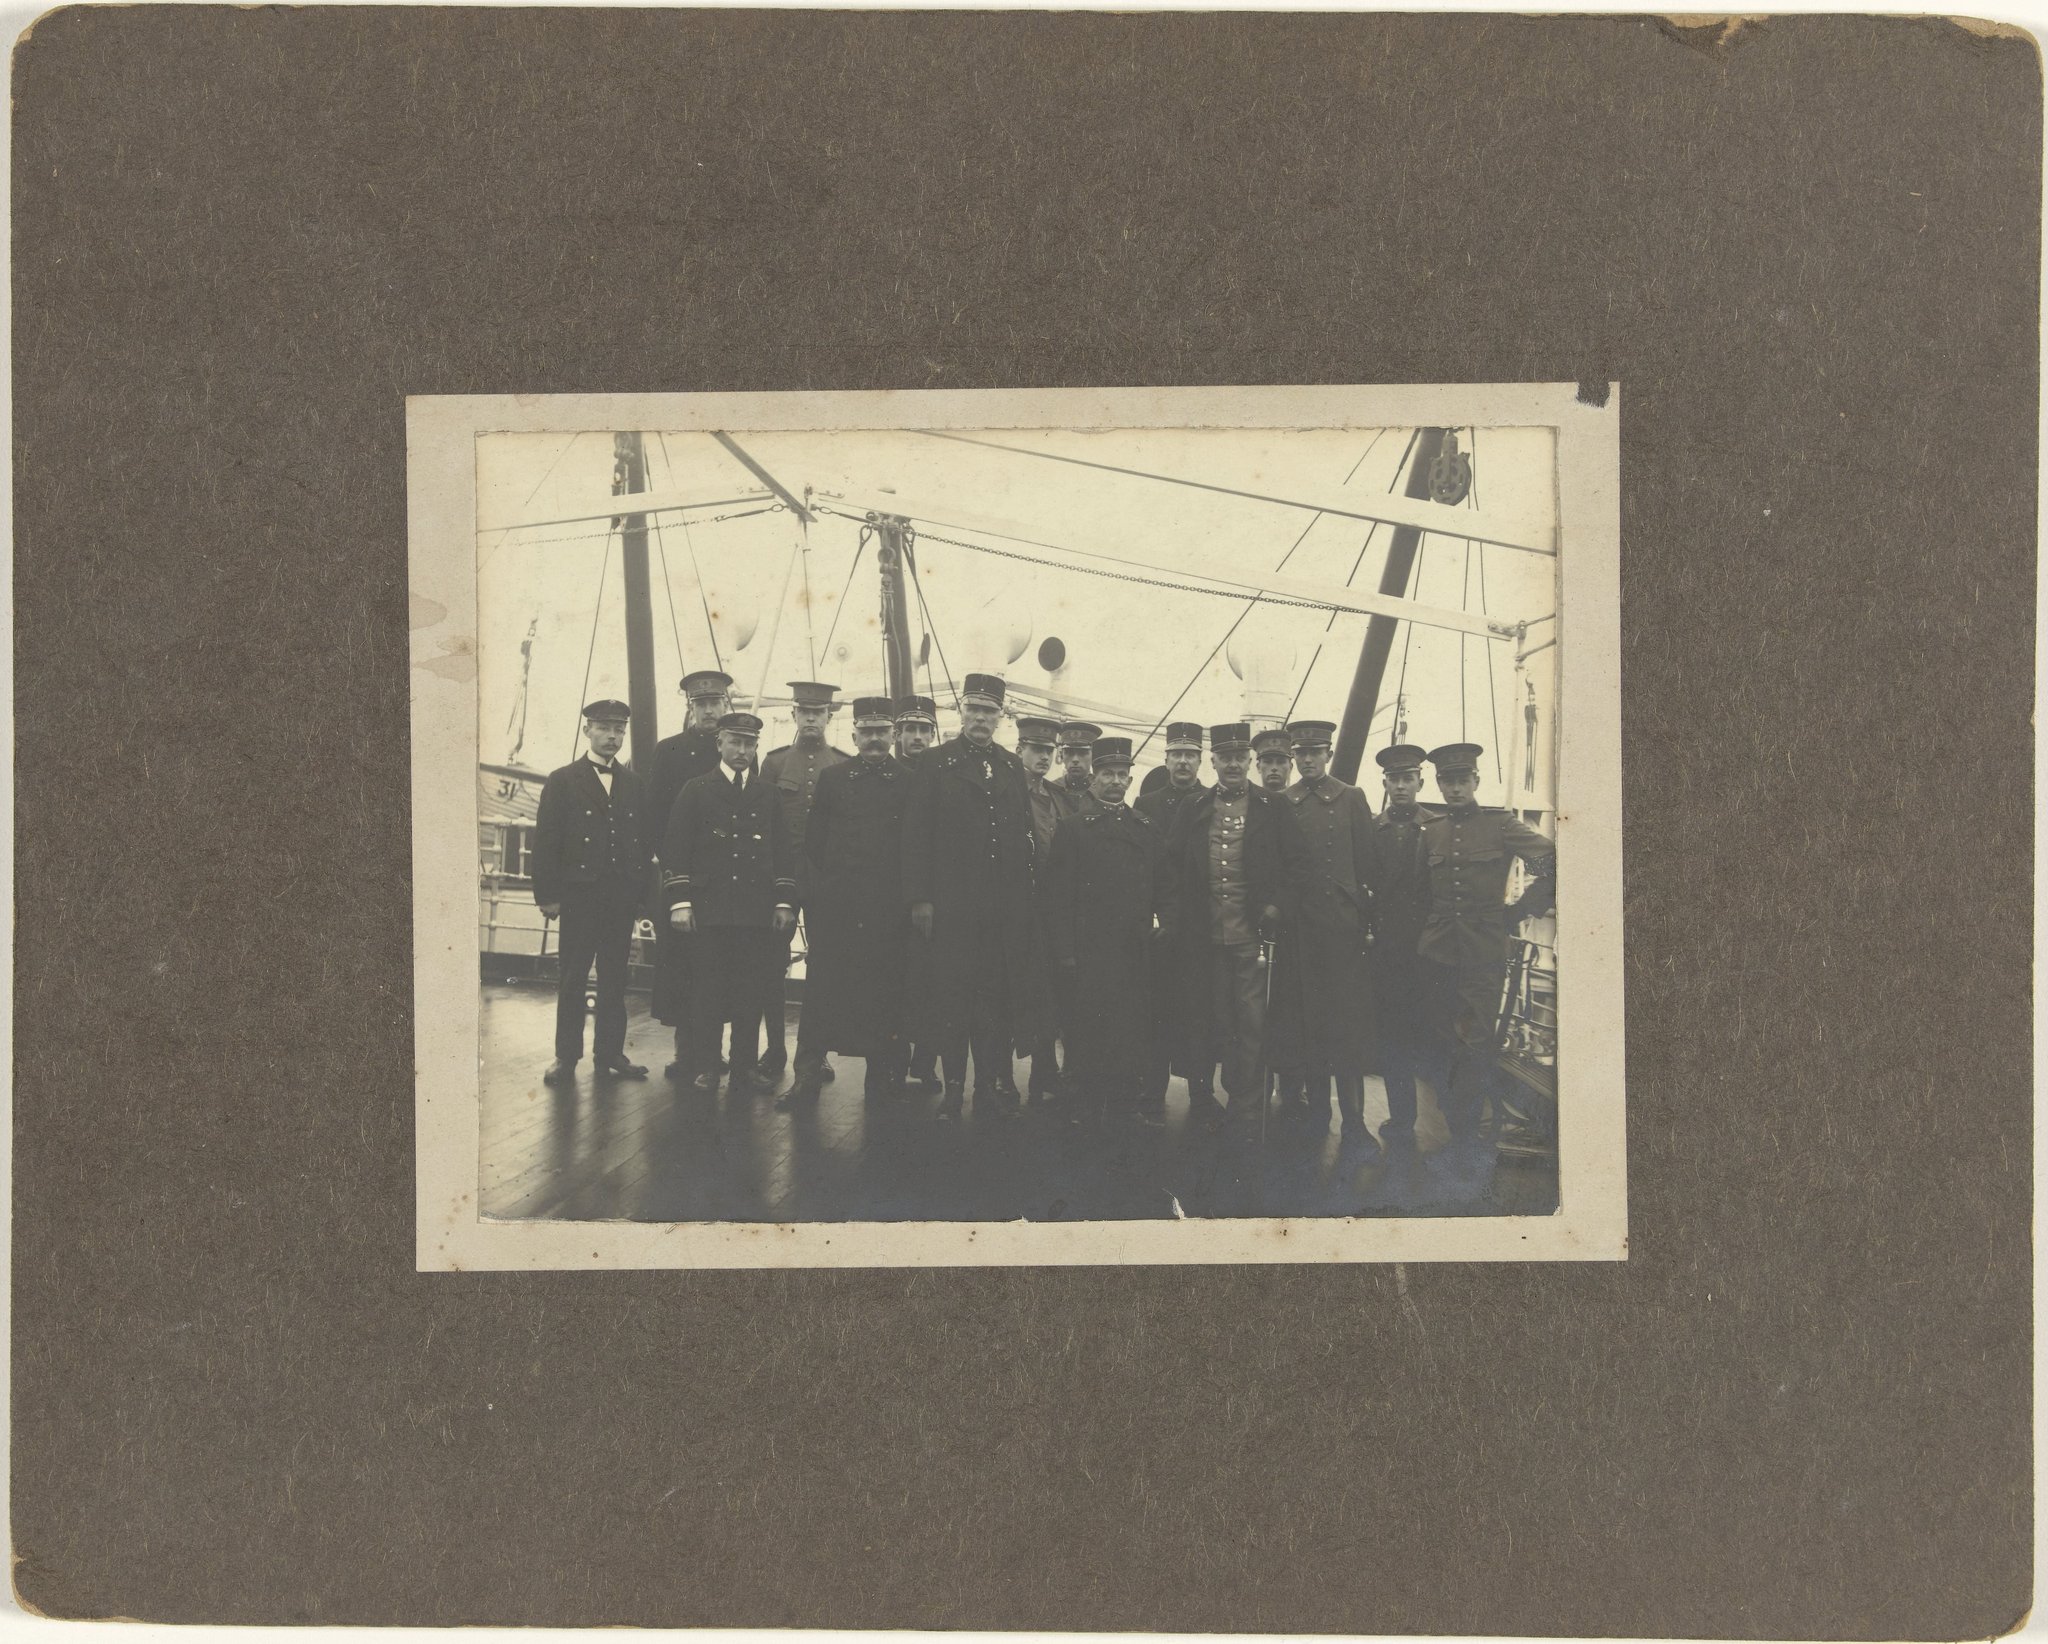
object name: photograph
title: Groepsportret van onbekende bemanning aan dek van een schip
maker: Anonymous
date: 1900-1930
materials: paper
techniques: gelatin silver print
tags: crew ~ ship